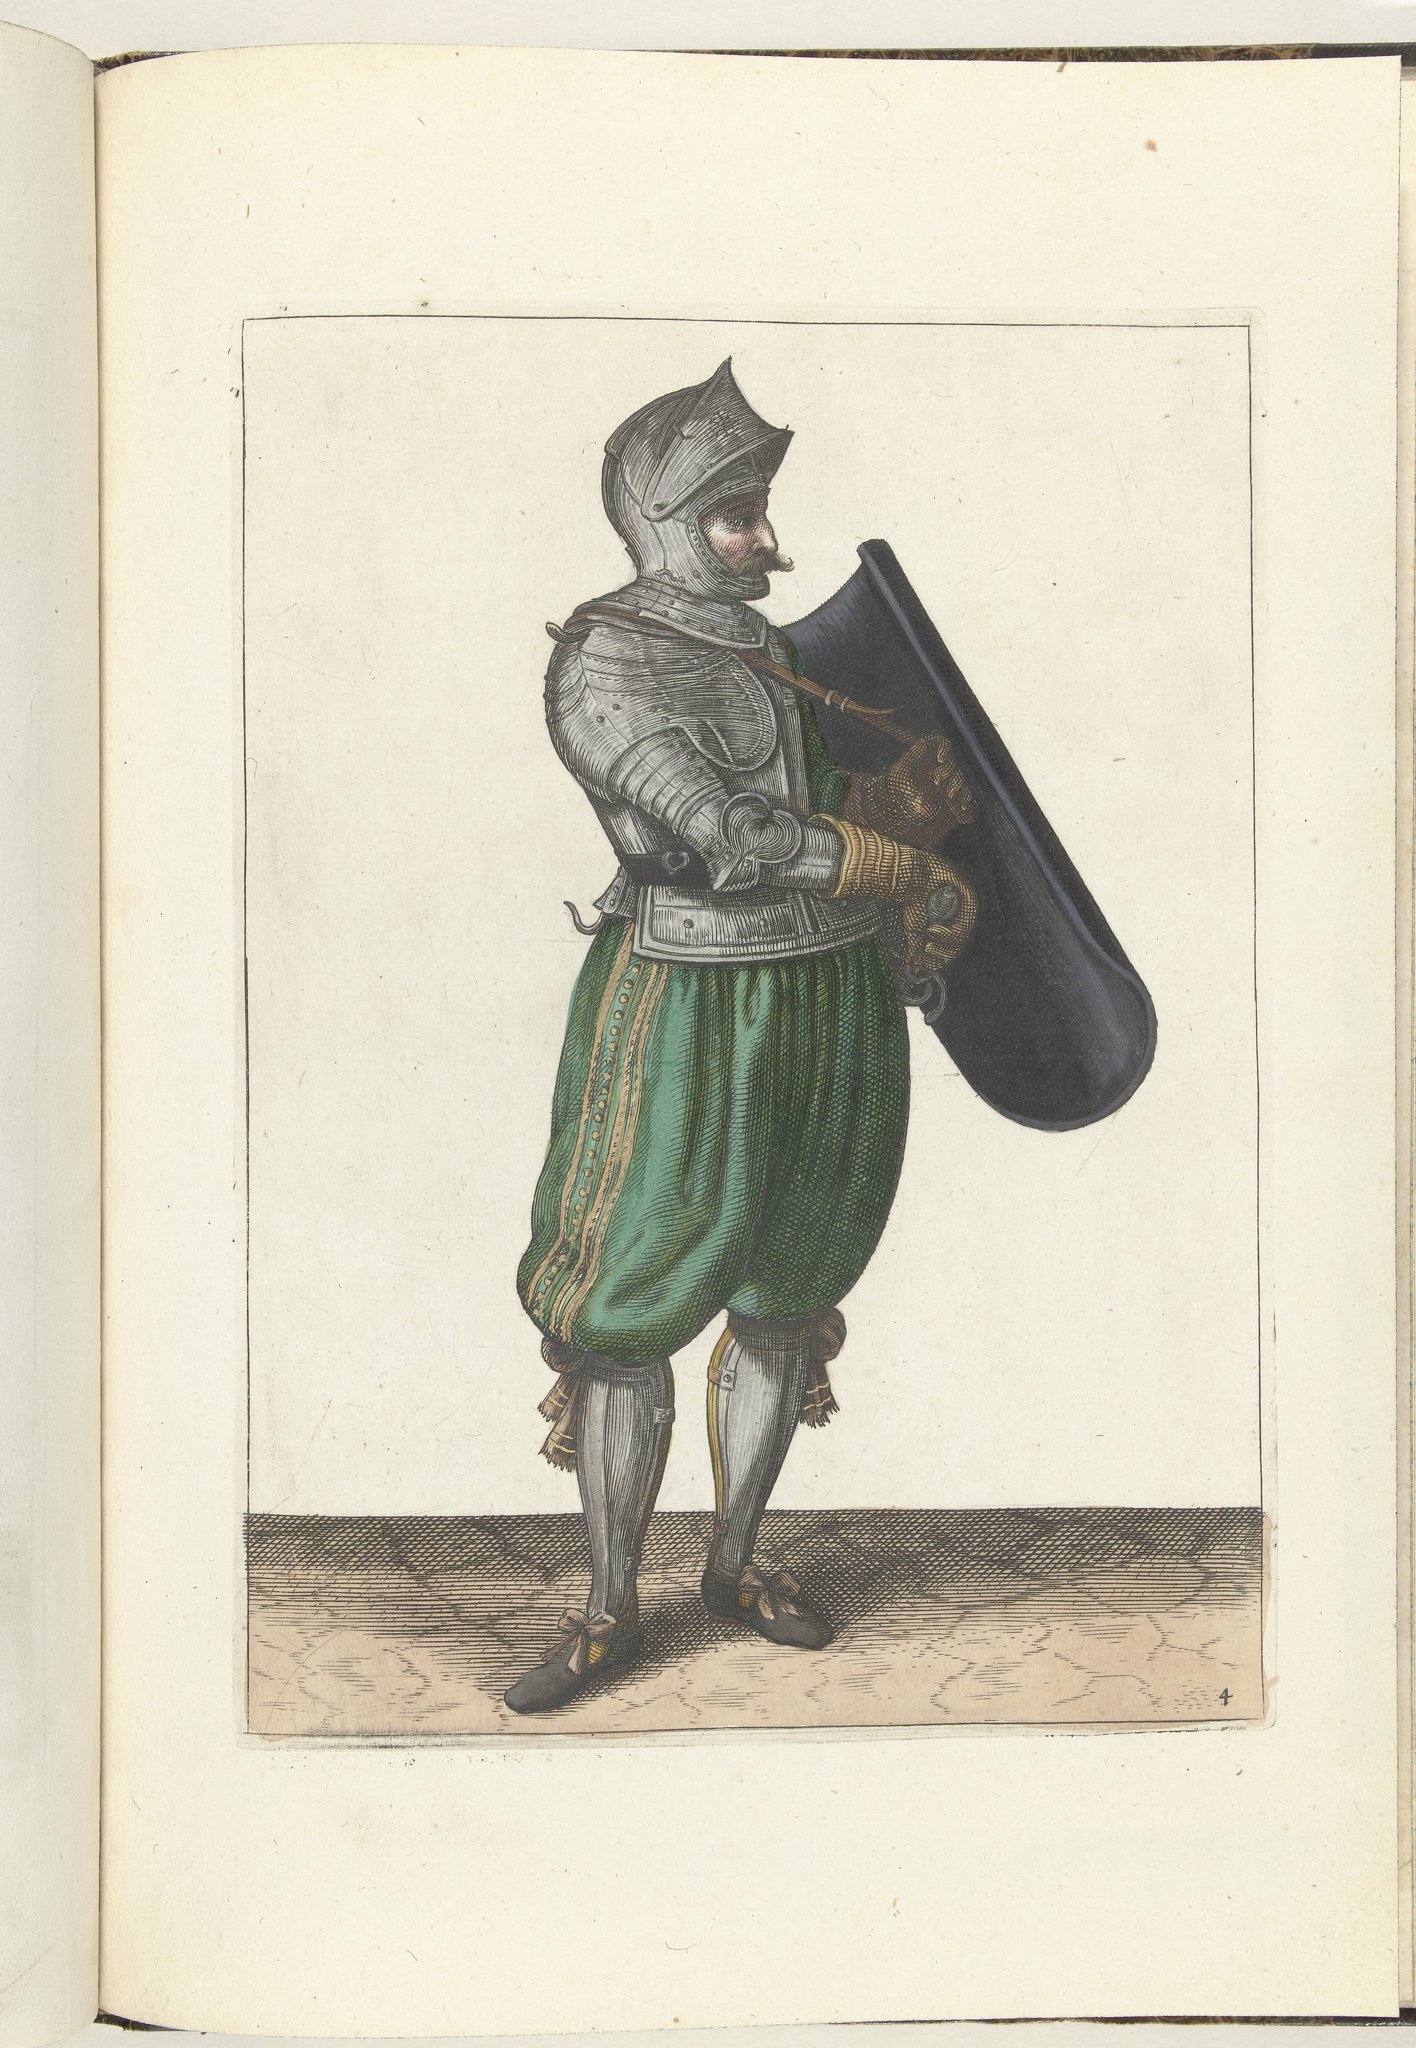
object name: print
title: De exercitie met de targe en rapier: de soldaat houdt de targe iets naar voren om de rapier te kunnen trekken (nr. 4), 1618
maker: Anonymous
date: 1616-1618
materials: paper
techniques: engraving, hand coloring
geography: northern netherlands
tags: the hague, maurice (prince of orange), handling of weapons ~ military training, weapons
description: Illustratie in: Adam van Breen, Nassauische Waffenhandelung / Kurtzer Bericht unnd Ahnzeigungh auff die Ab-bildungh der Figuren / den rechten brauch alles des jenigen betreffend / so einem Soldaten von nöten / in der handlung der Targa, met dem Degen [incompleet exemplaar], 1618?, plaat 4. Dit is een Duitse editie van Adam van Breens De Nassausche Wapen-Handelinge, van Schilt, Spies, Rappier ende Targe : beyde figuerlick afgebeelt, ende gestelt na de nieu ordening [van] ... Maurits van Nassau, 's-Gravenhage, [Aert Meuris] 1618. In het exemplaar in de collectie van de Rijksmuseum Research Library (326 F 23).